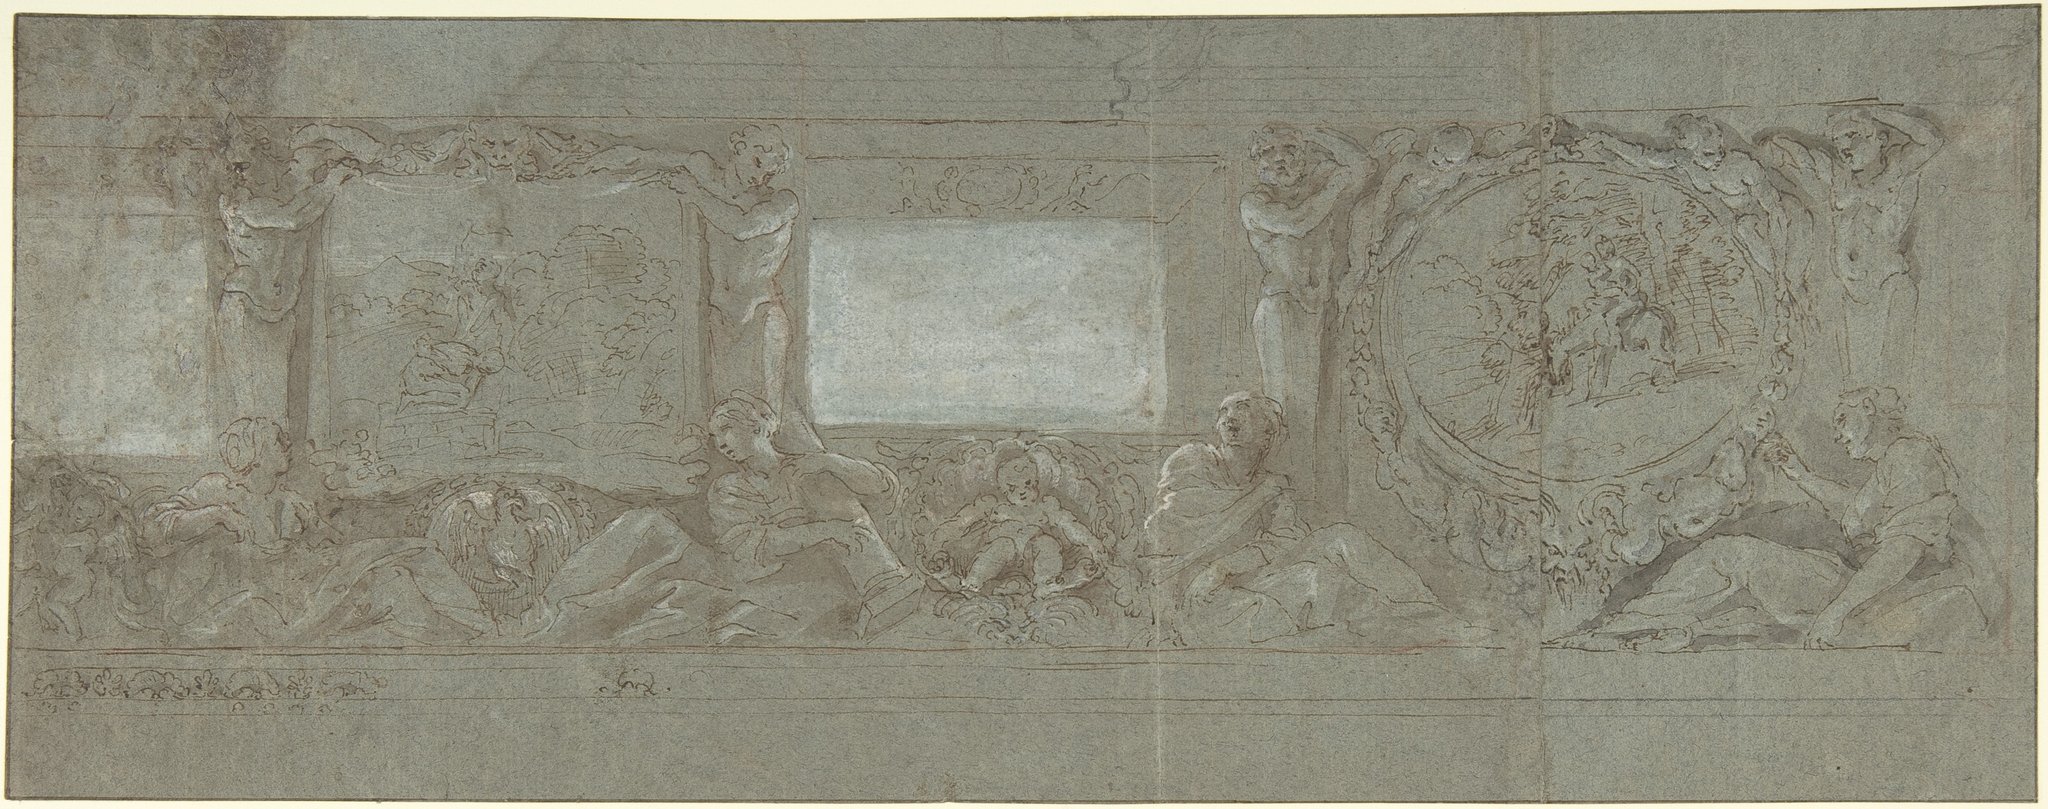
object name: drawing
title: Design for a Wall Decoration with the Sacrifice of Abraham and the Flight into Egypt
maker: giovanni lanfranco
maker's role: artist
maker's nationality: italian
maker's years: 1582-1647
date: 1582-1647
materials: chalk, gouache, ink, paper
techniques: brush, highlighting, pen, wash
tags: infants,men,horses,abraham